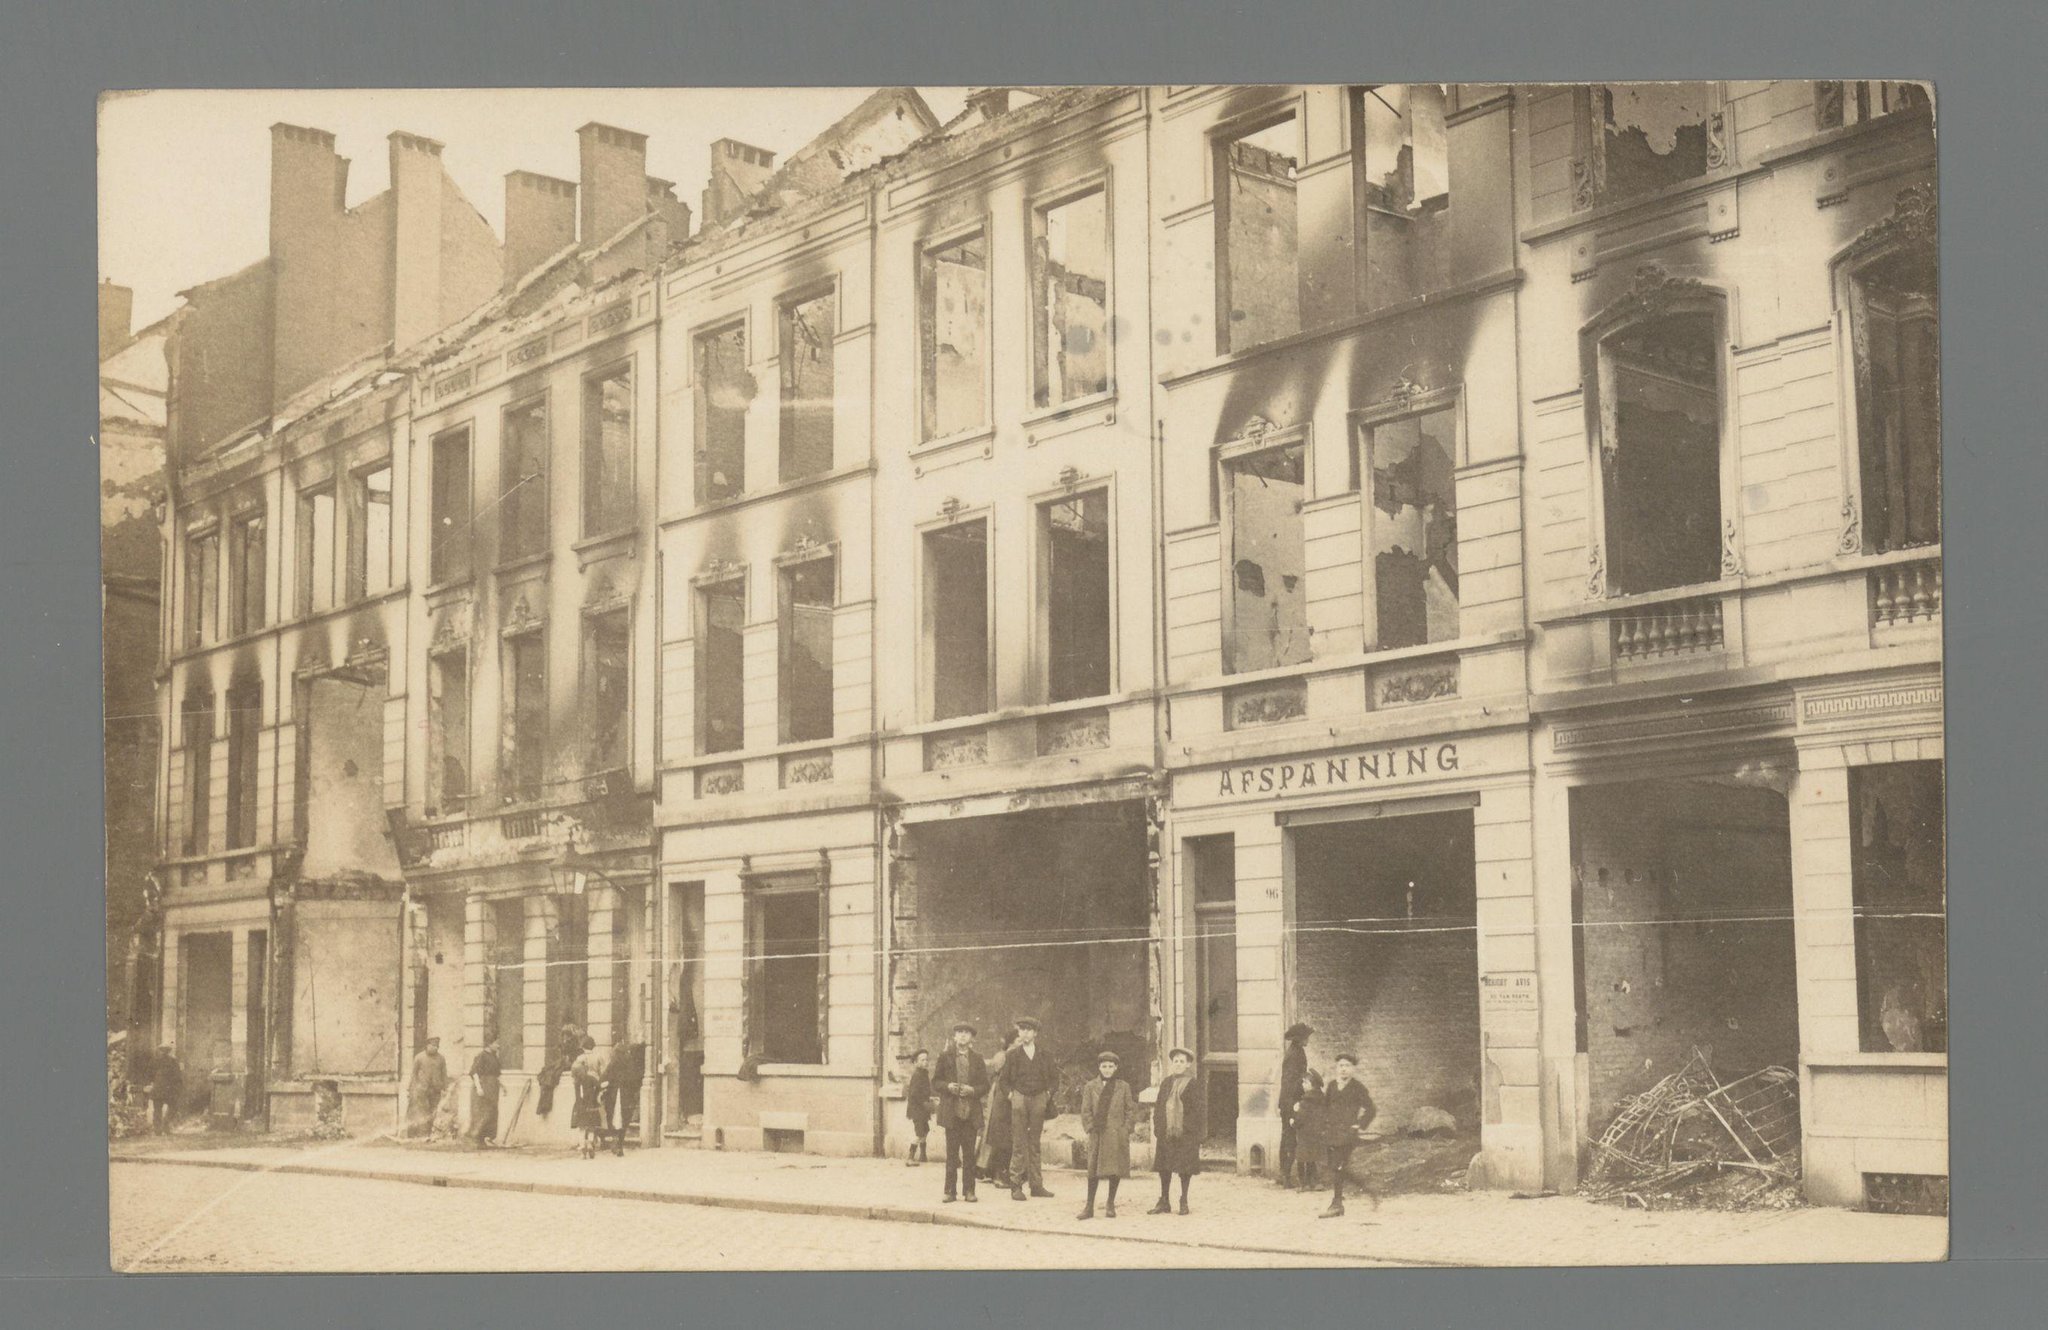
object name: photograph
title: Verwoeste Antwerpse gebouwen na bombardement van oktober 1914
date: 1914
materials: photographic support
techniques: photography, writing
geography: antwerp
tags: city-view, and landscape with man-made constructions (+ city(-scape) with figures, staffage), bombardment, demolishing (of conquered city), antwerp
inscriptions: inscription: ‘Bombardement. Antwerpen/ Oct. 1914.’